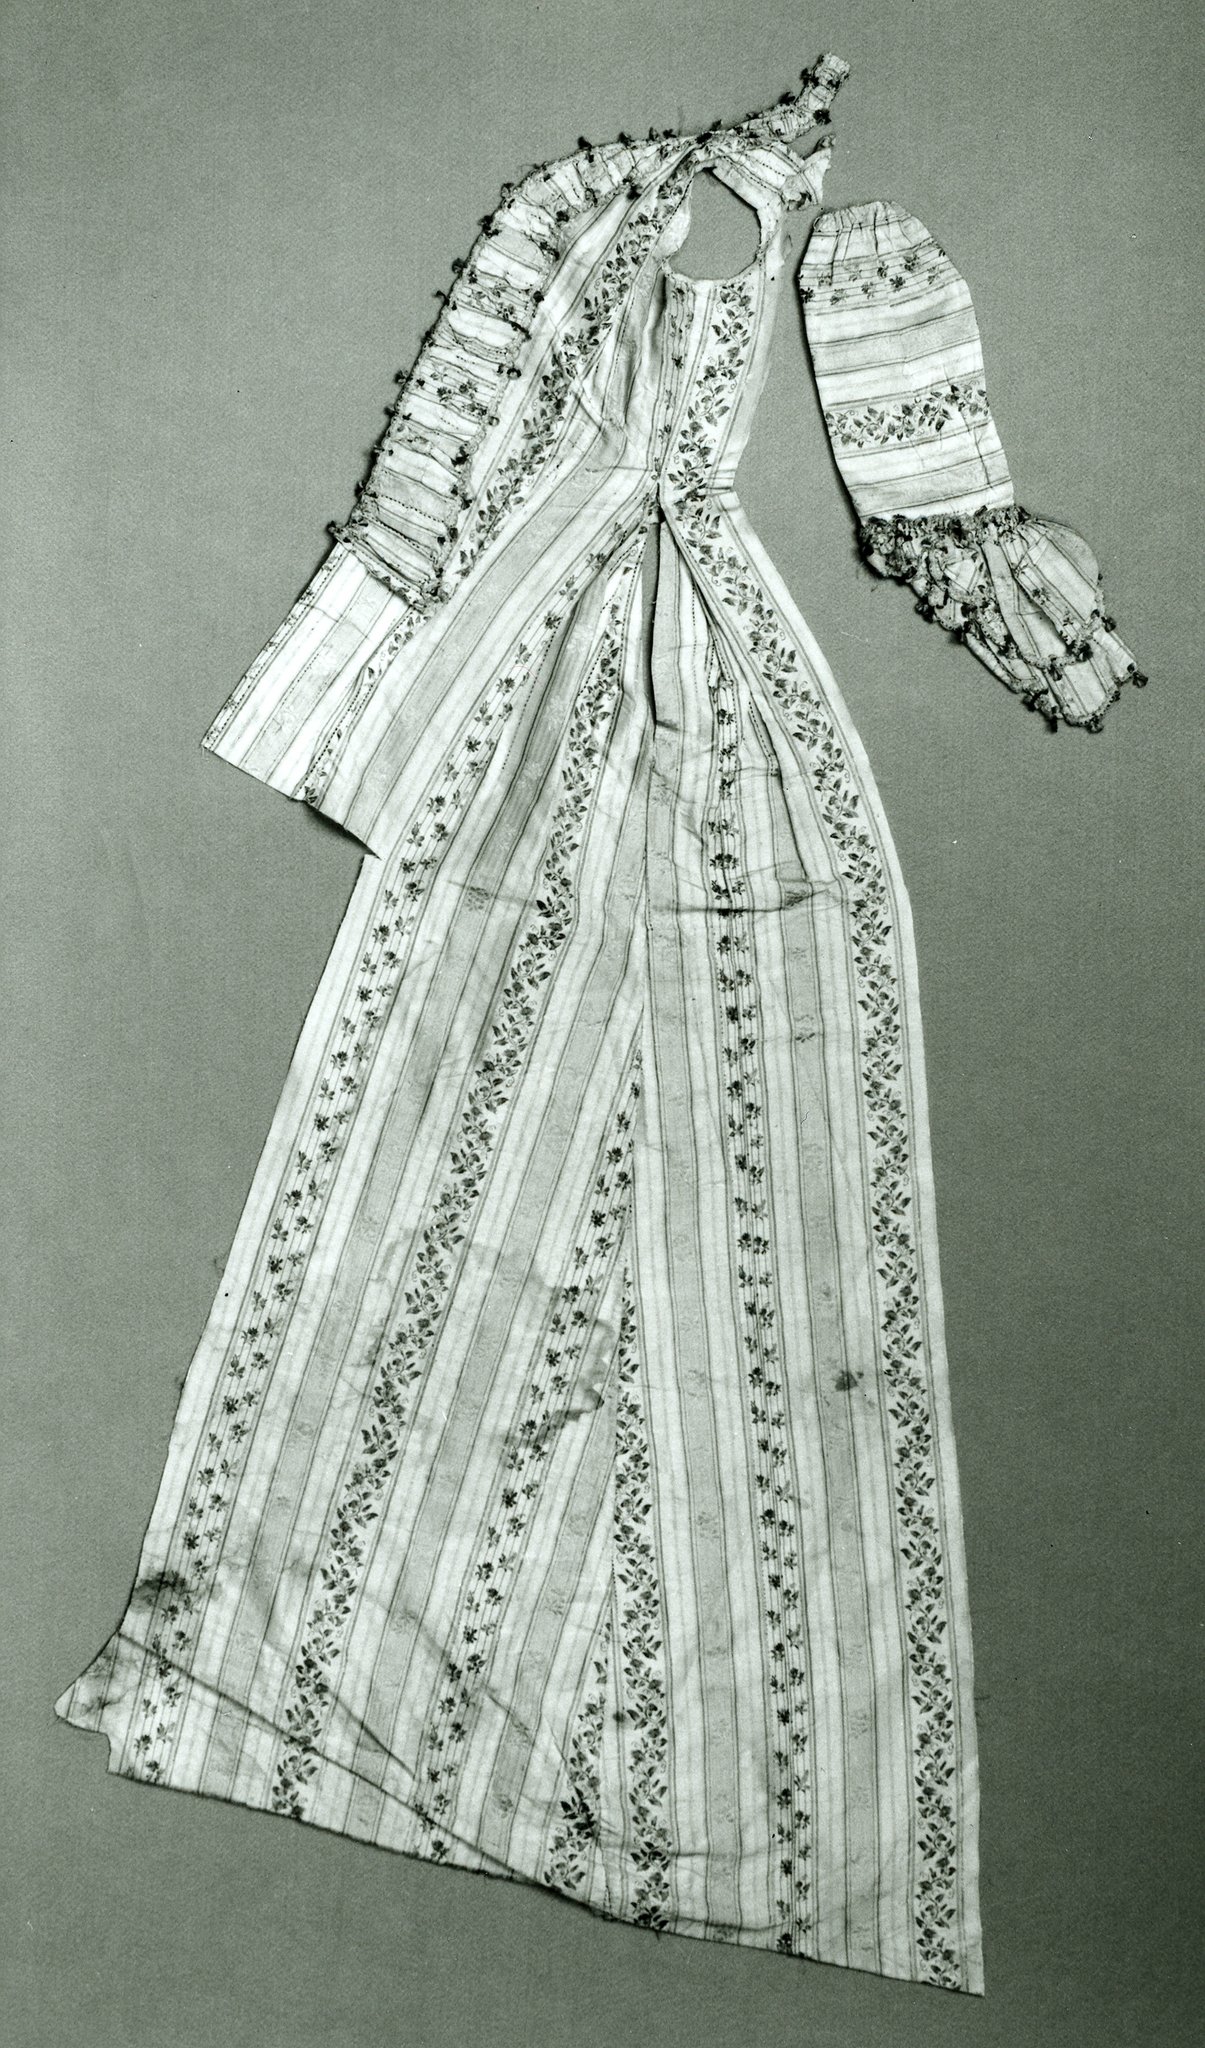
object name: dress fragment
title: Part of a dress and twenty-five fragments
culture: french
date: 1701-1800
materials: silk